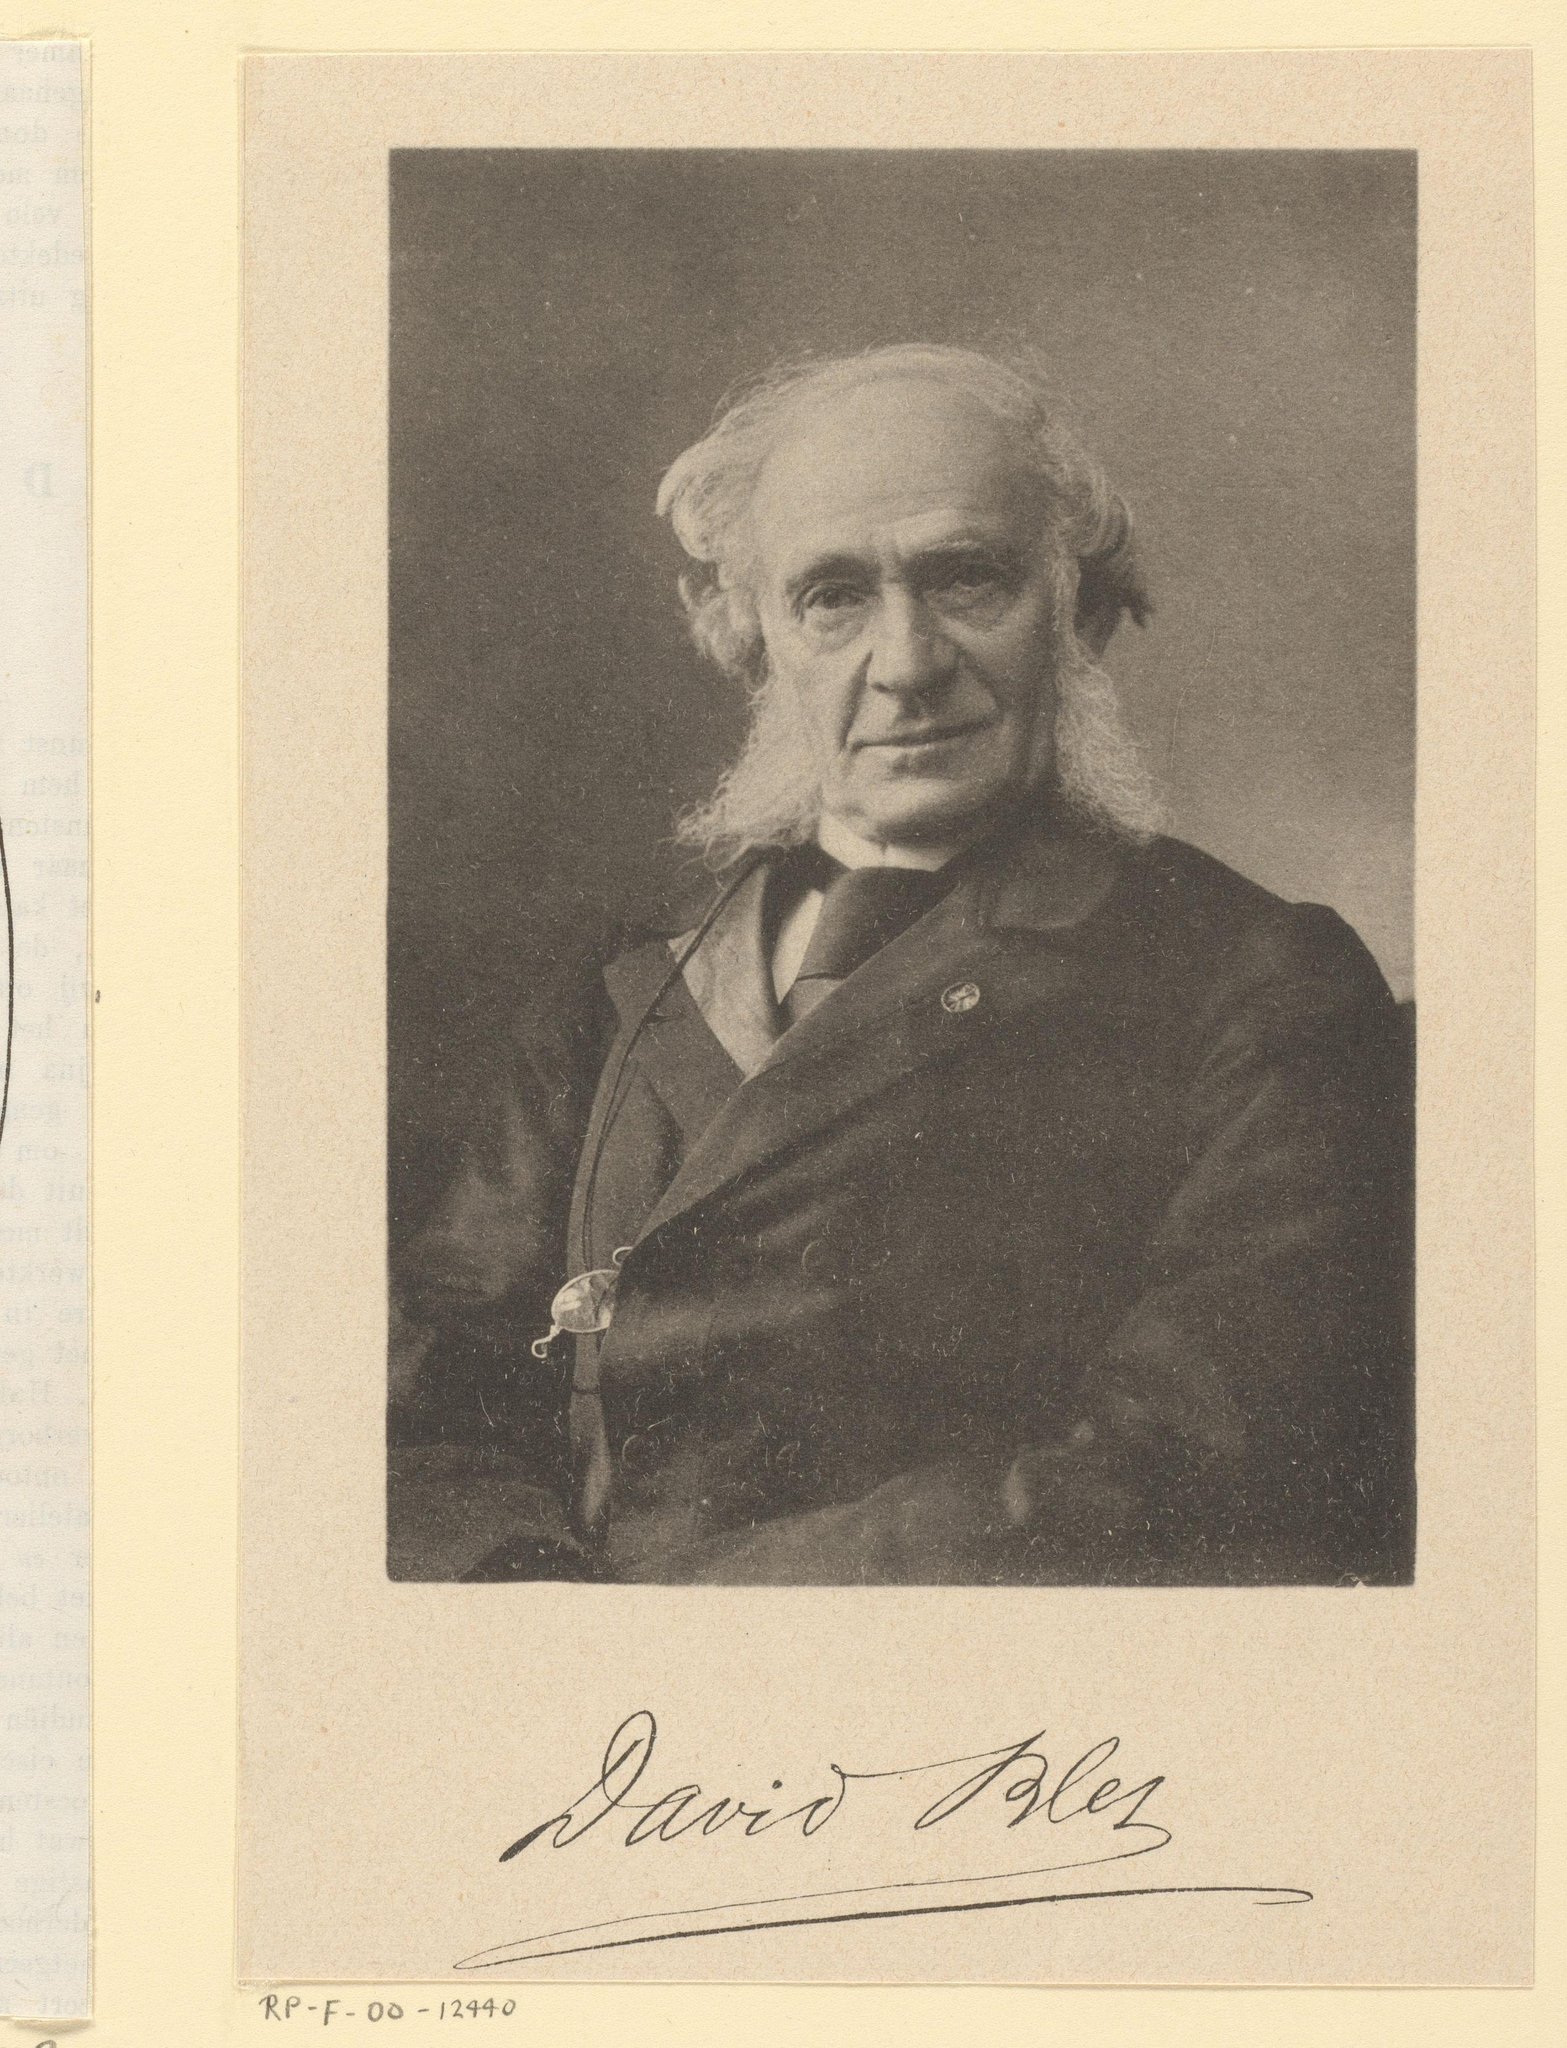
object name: photomechanical print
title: Portret van de schilder David Bles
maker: Anonymous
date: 1890-1899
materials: paper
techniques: photograph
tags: the hague, painter, print maker, draughtsman, david bles, historical persons, portrait, self-portrait of painter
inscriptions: signature: ‘David Bles’